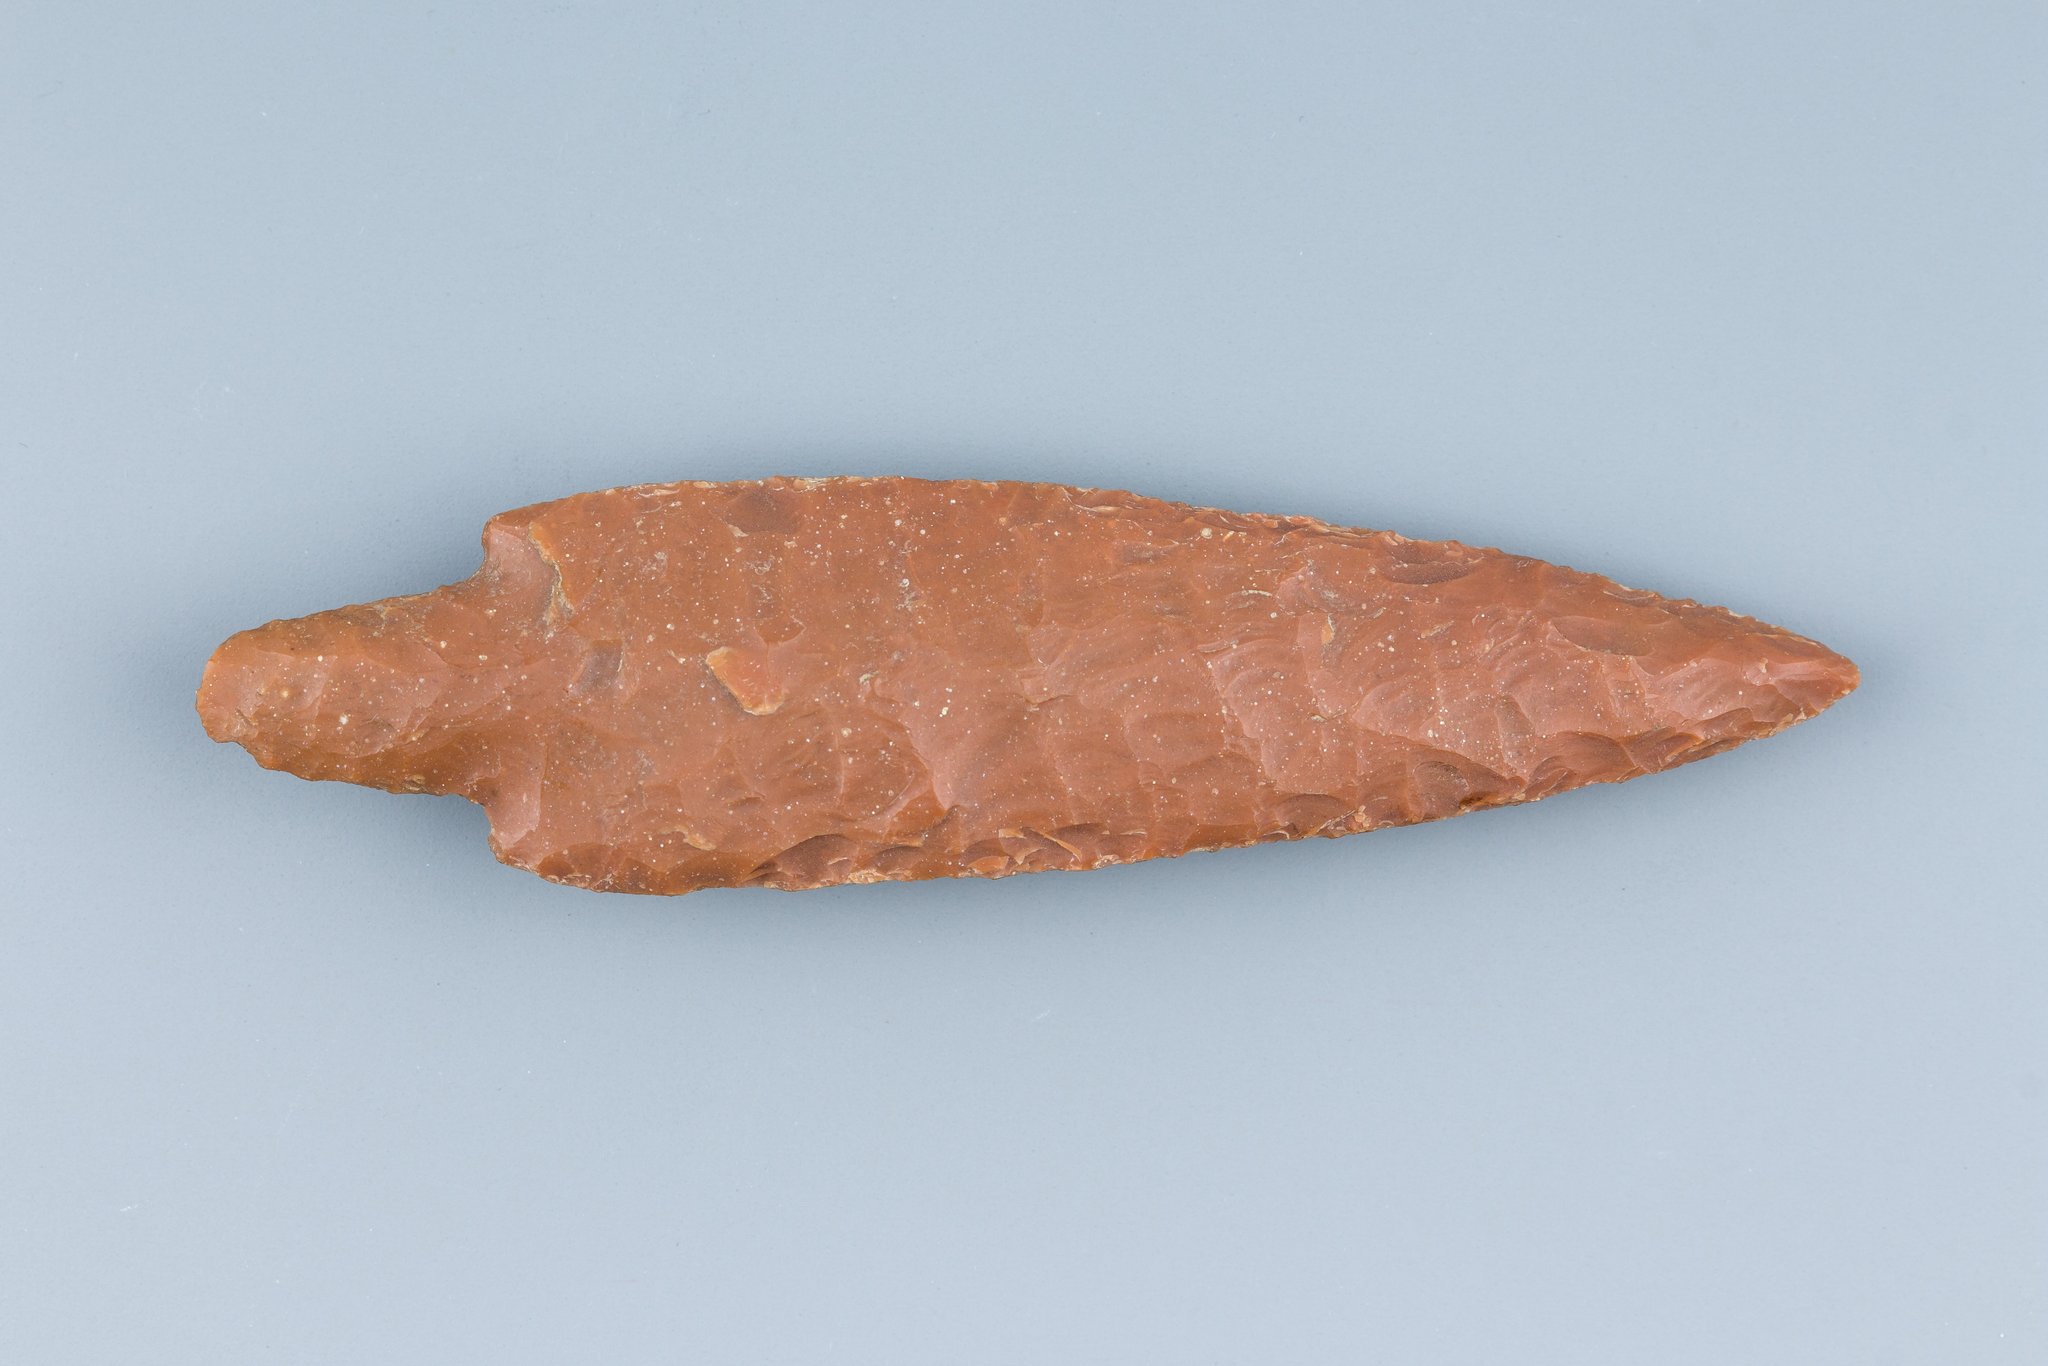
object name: arrowhead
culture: italian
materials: stone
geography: italy